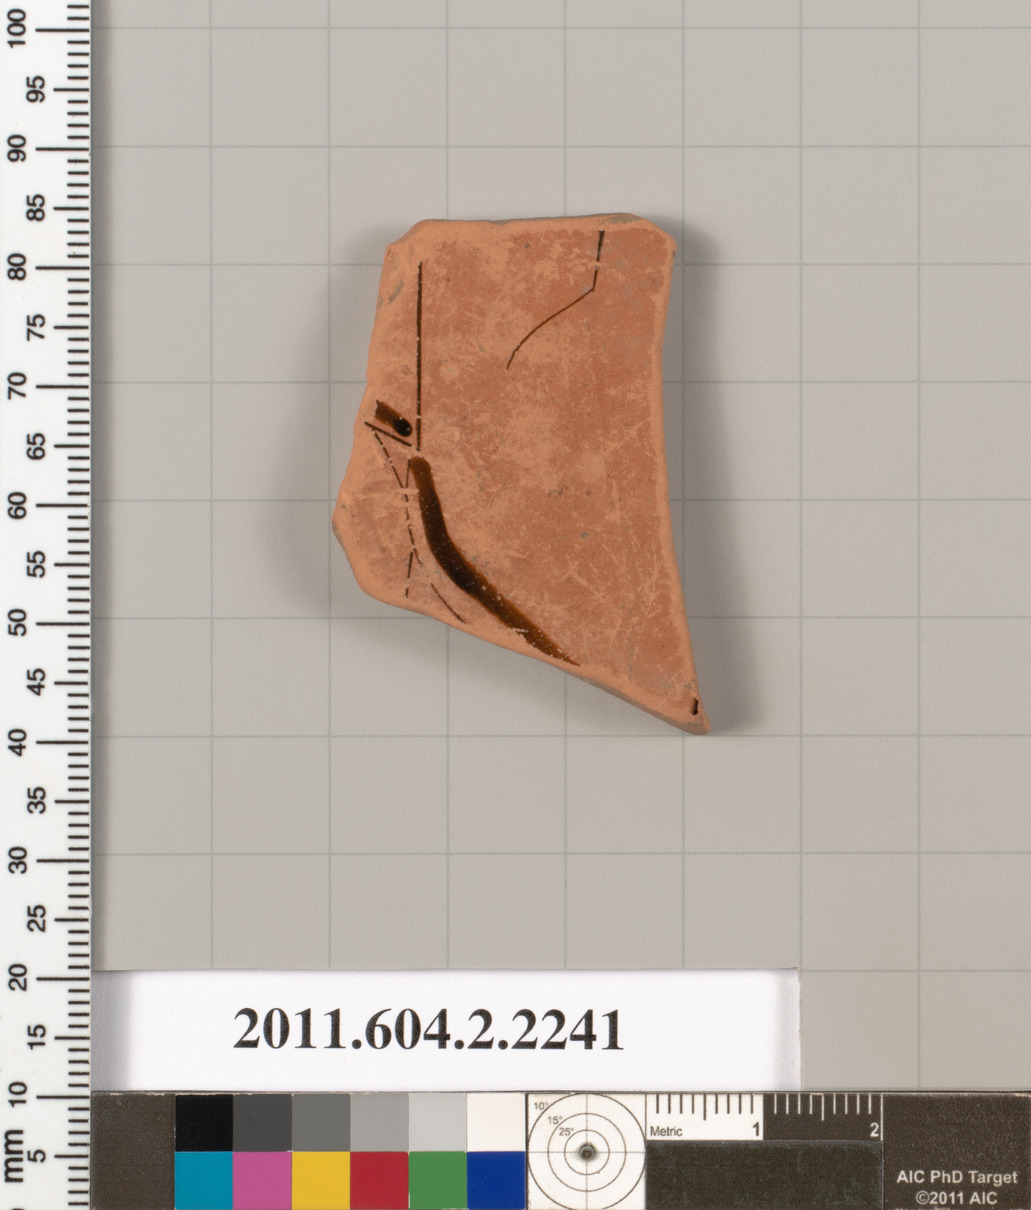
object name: pot fragment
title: Terracotta fragment of a pot; unglazed on the inside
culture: greek, attic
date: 450-426 BCE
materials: terracotta